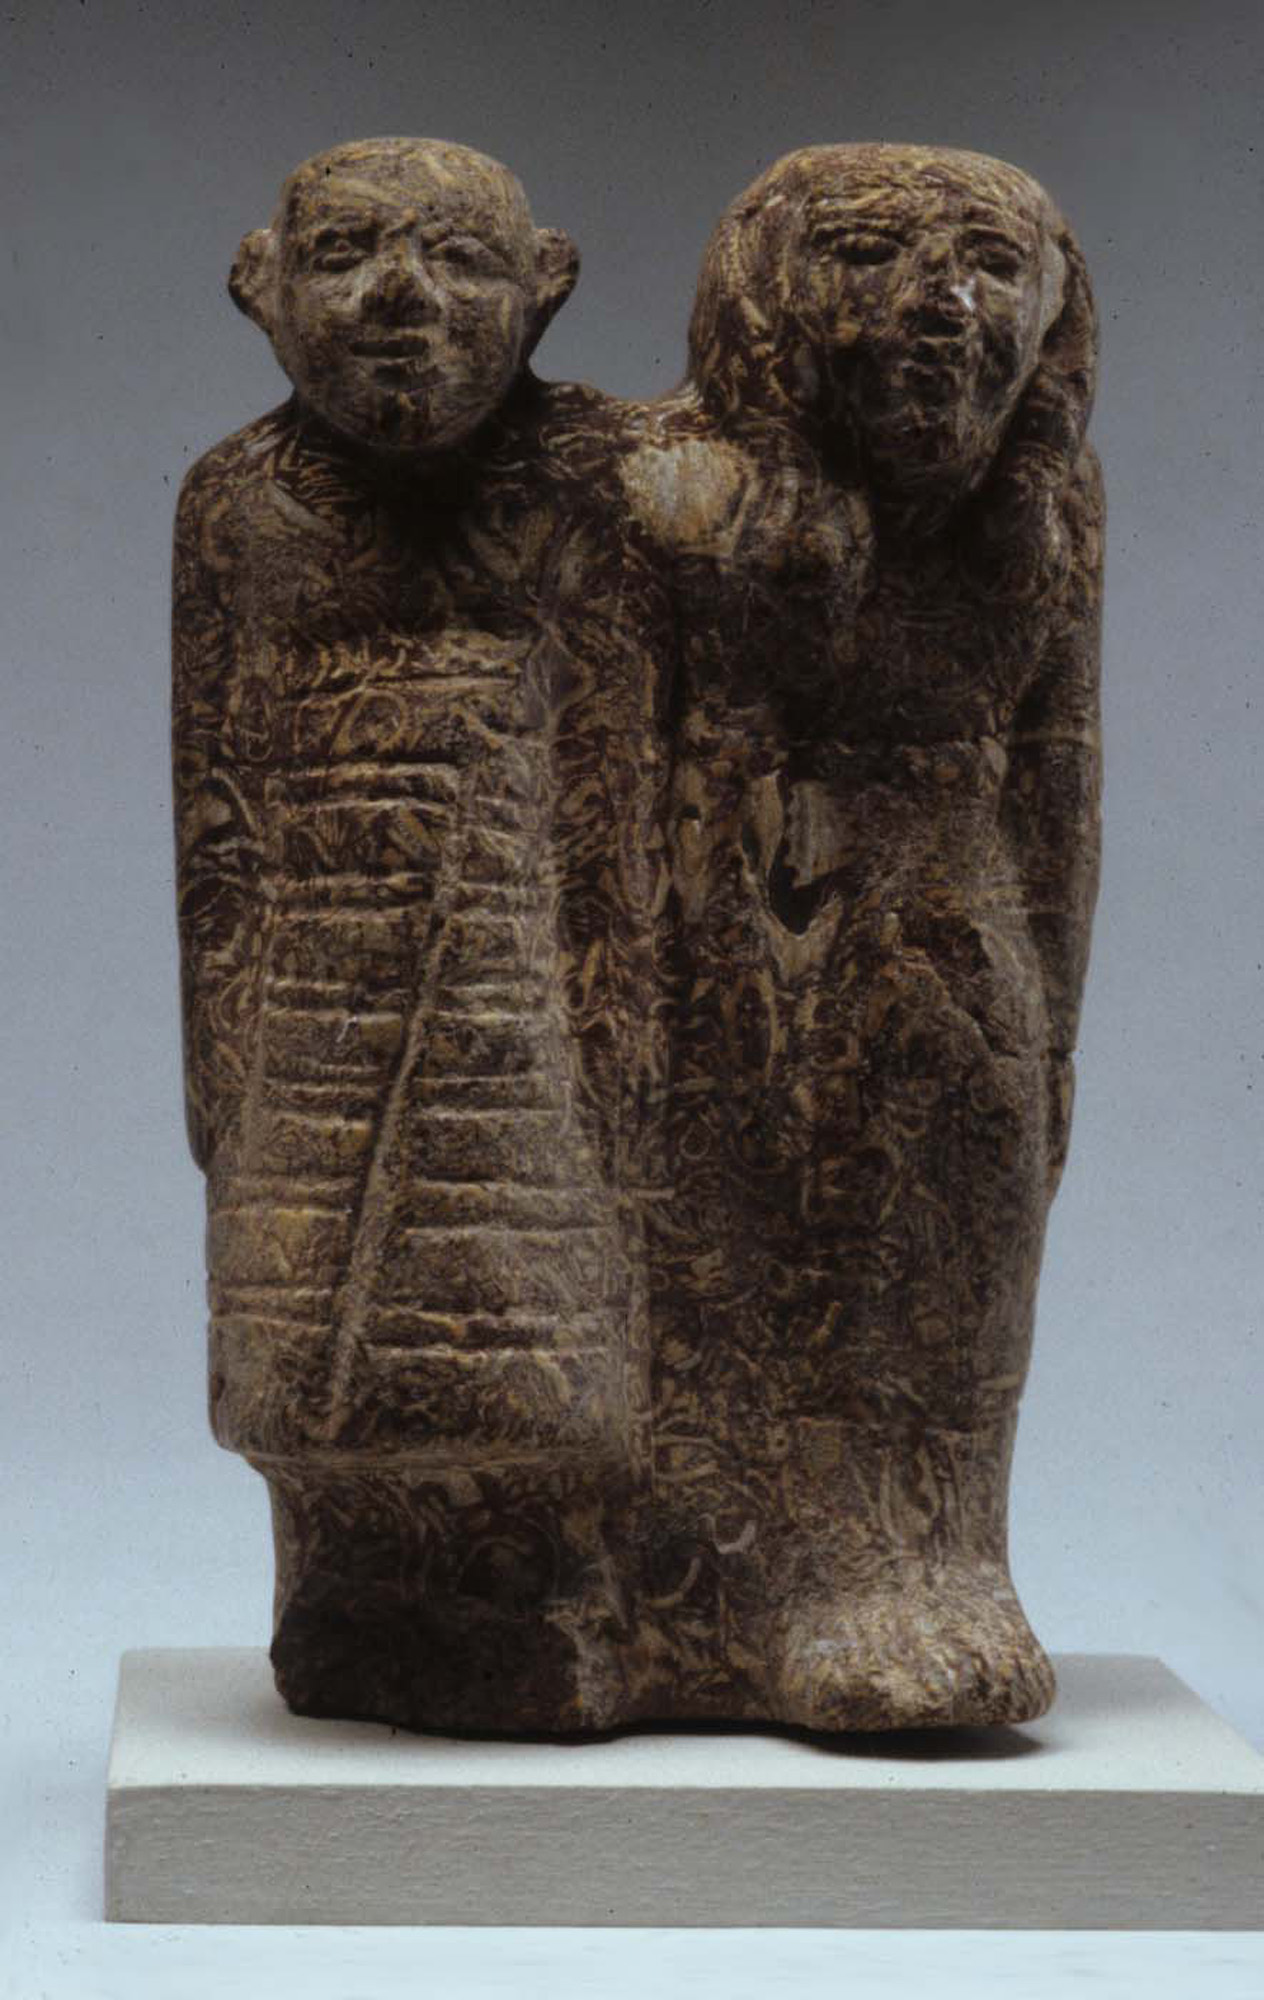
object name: statuette group, man and woman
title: Family group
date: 1802-1640 BCE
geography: egypt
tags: men,women